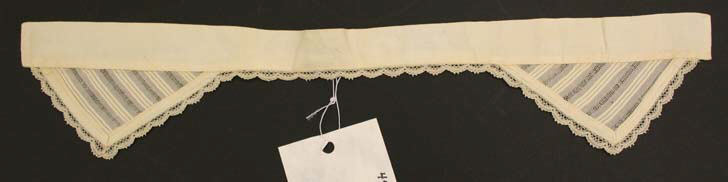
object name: collar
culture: american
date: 1840-1849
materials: linen